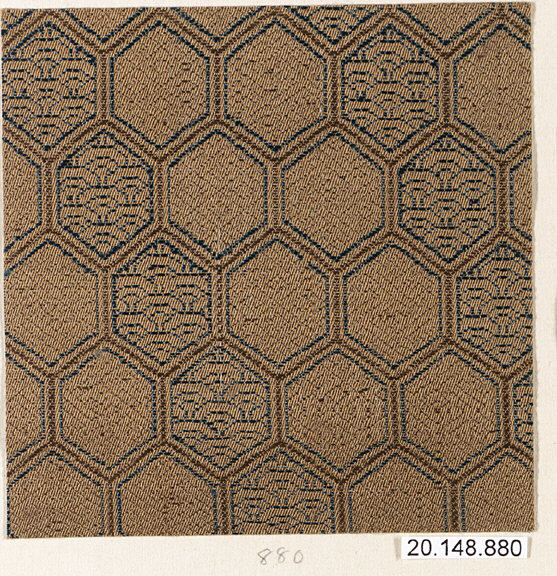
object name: piece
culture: japanese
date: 1701-1800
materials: silk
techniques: compound weave